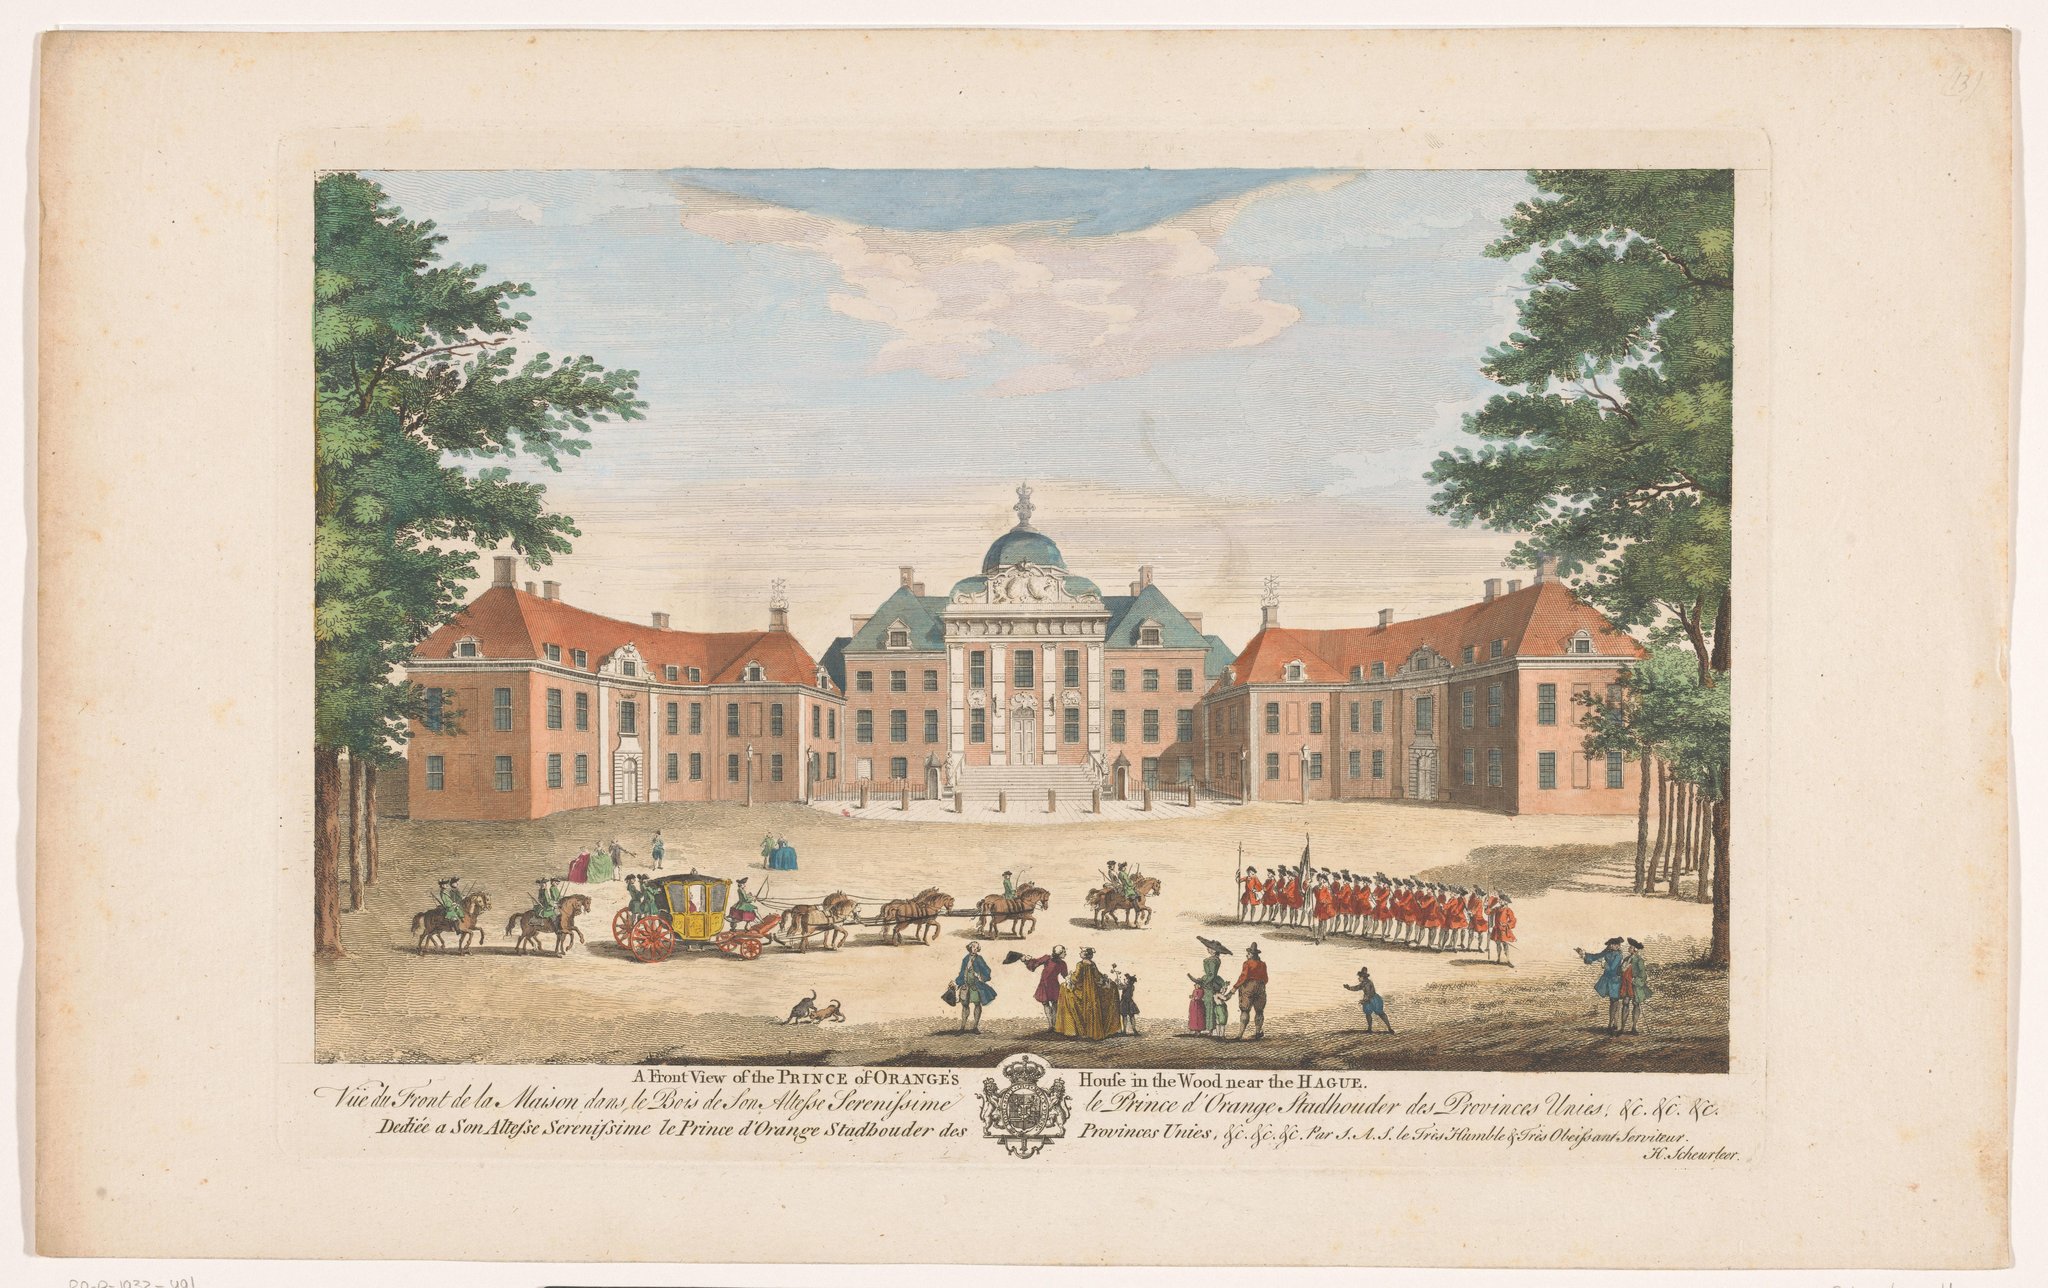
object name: print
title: Gezicht op de voorzijde van het Paleis Huis ten Bosch te Den Haag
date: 1734-1768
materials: paper, watercolor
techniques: brush, etching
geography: netherlands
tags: palace, four-wheeled vehicle drawn by more than three animals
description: Links rijdt een koets getrokken door zes paarden.